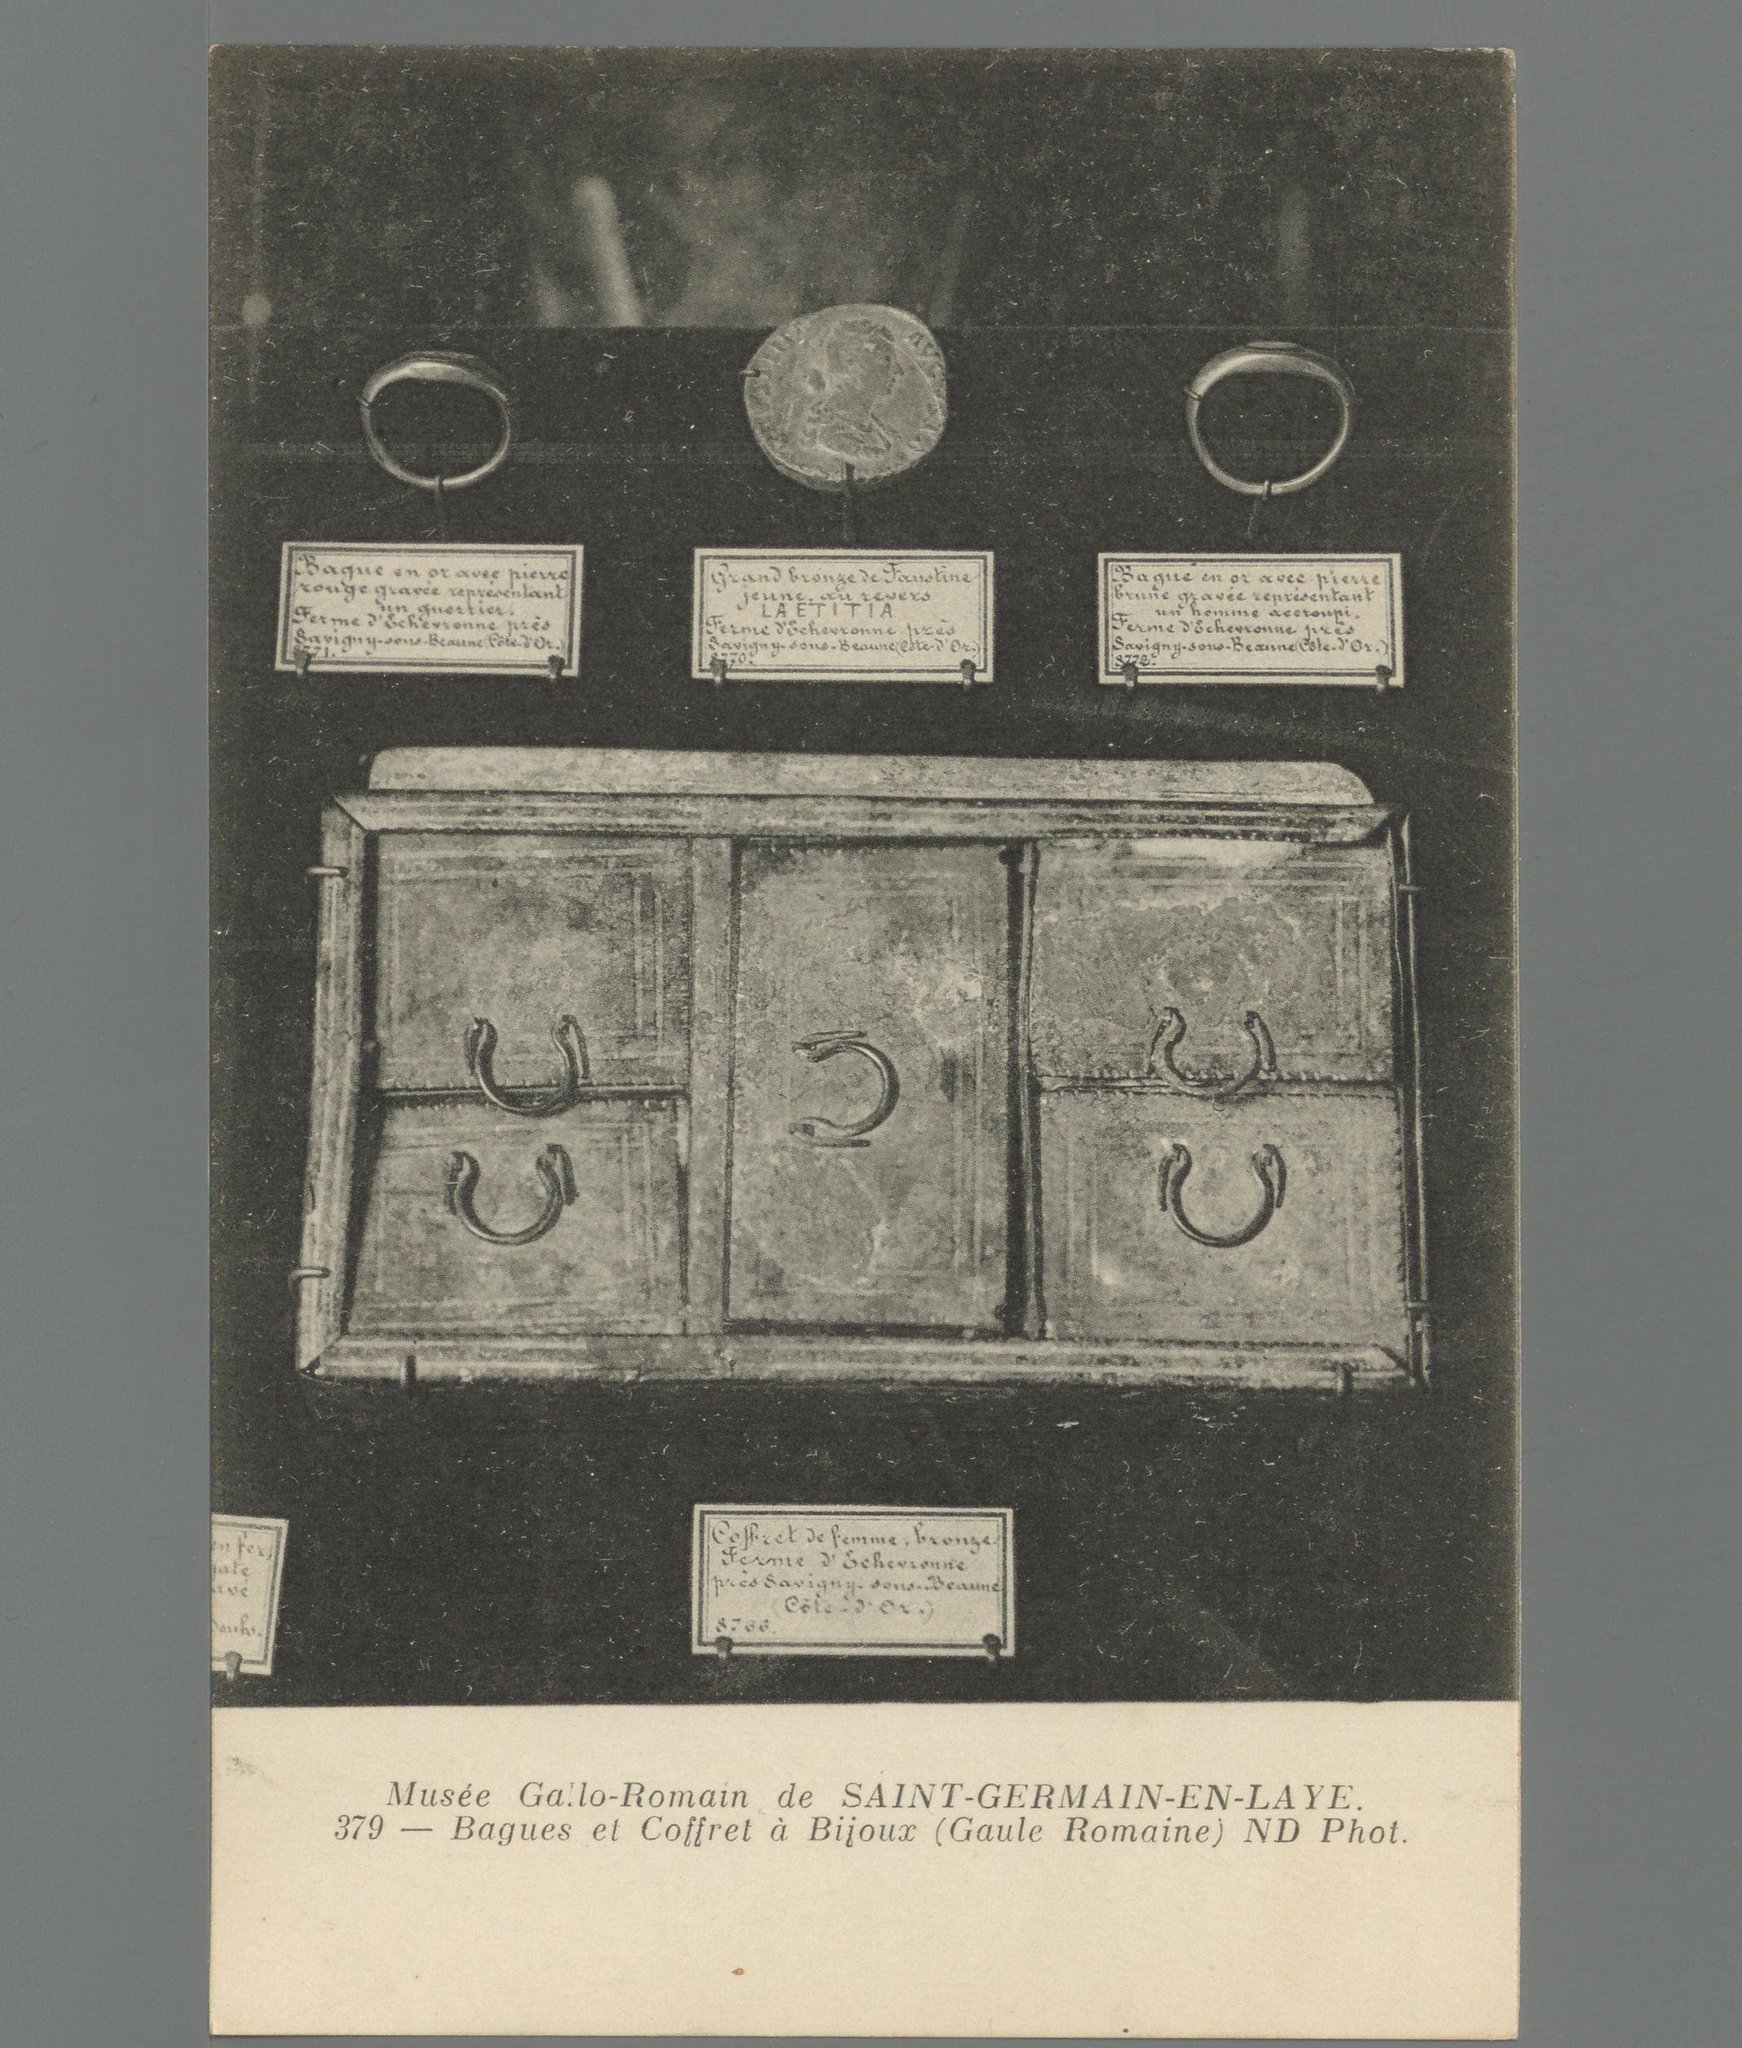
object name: ansichtkaart, prentbriefkaart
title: Bagues et Coffret à Bijoux (Gaule Romaine)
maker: Anonymous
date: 1903-1918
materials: cardboard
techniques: photograph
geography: paris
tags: ornaments, jewels, permanent exhibition, museum